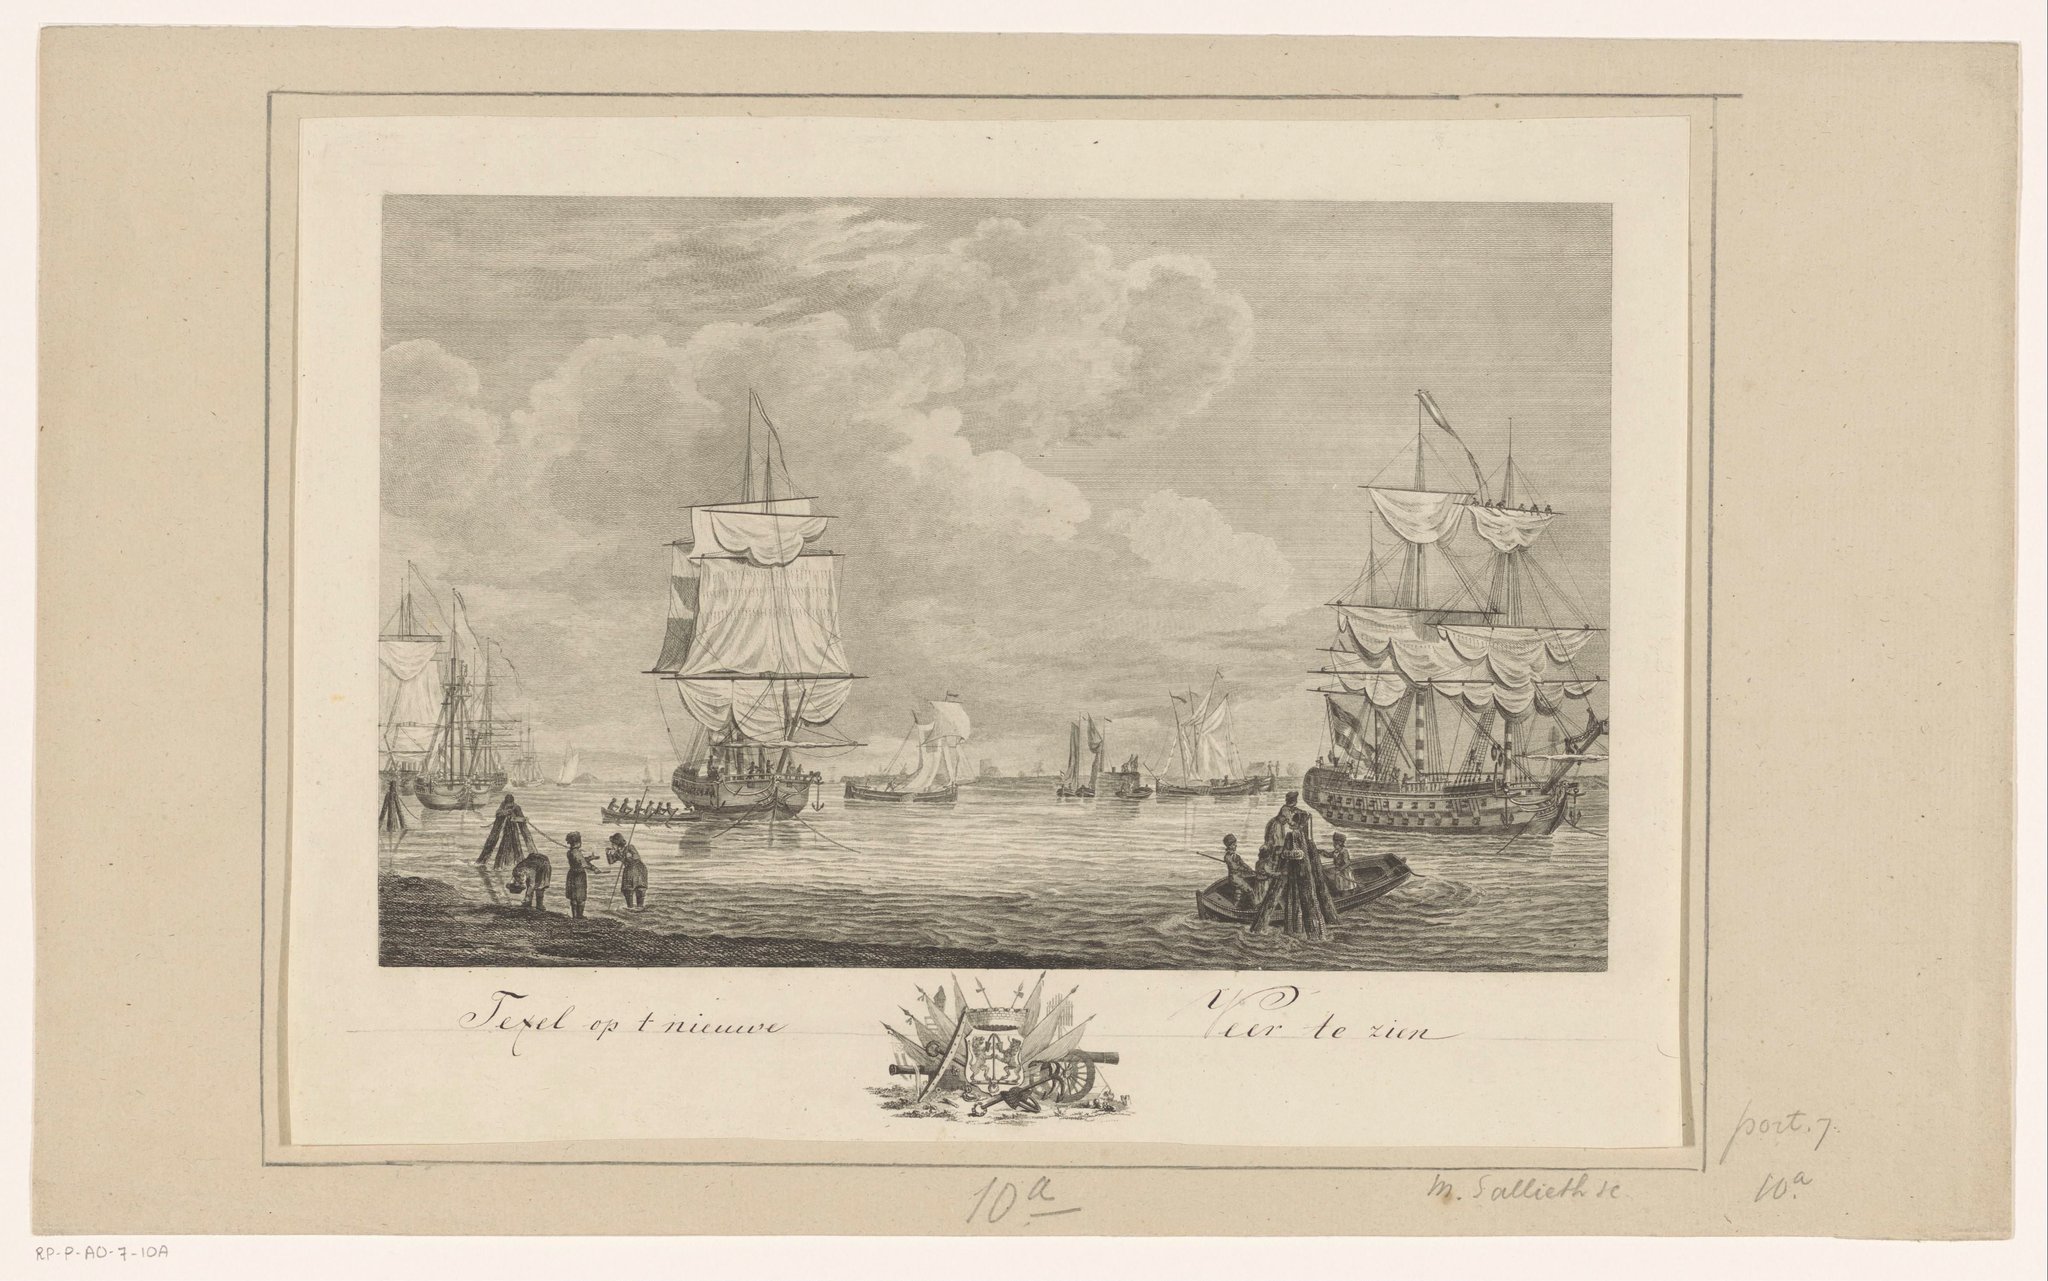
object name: print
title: Gezicht op Texel bij het Nieuwe Veer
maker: mathias de sallieth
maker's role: print maker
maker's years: 1749-1791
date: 1781-1787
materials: ink, paper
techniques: etching, pen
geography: rotterdam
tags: coat of arms (as symbol of the state, etc.), coat of arms (as symbol of the state, etc.) (+ city; municipal), sailing-ship, sailing-boat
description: Staat avant la lettre van RP-P-1907-2161. Latere staat ook gebruikt in: Aa, Cornelis van der. Atlas van de zeehavens der Bataafsche Republiek. Met derzelver beschrijvingen in XXXI kunstplaaten / Atlas van de zeehavens der Bataafsche Republiek, die van Batavia en Onrust. Mitsgaders de afbeeldingen van de haringvisscherij en de walvischvangst (…). Amsterdam: Evert Maaskamp, 1805.